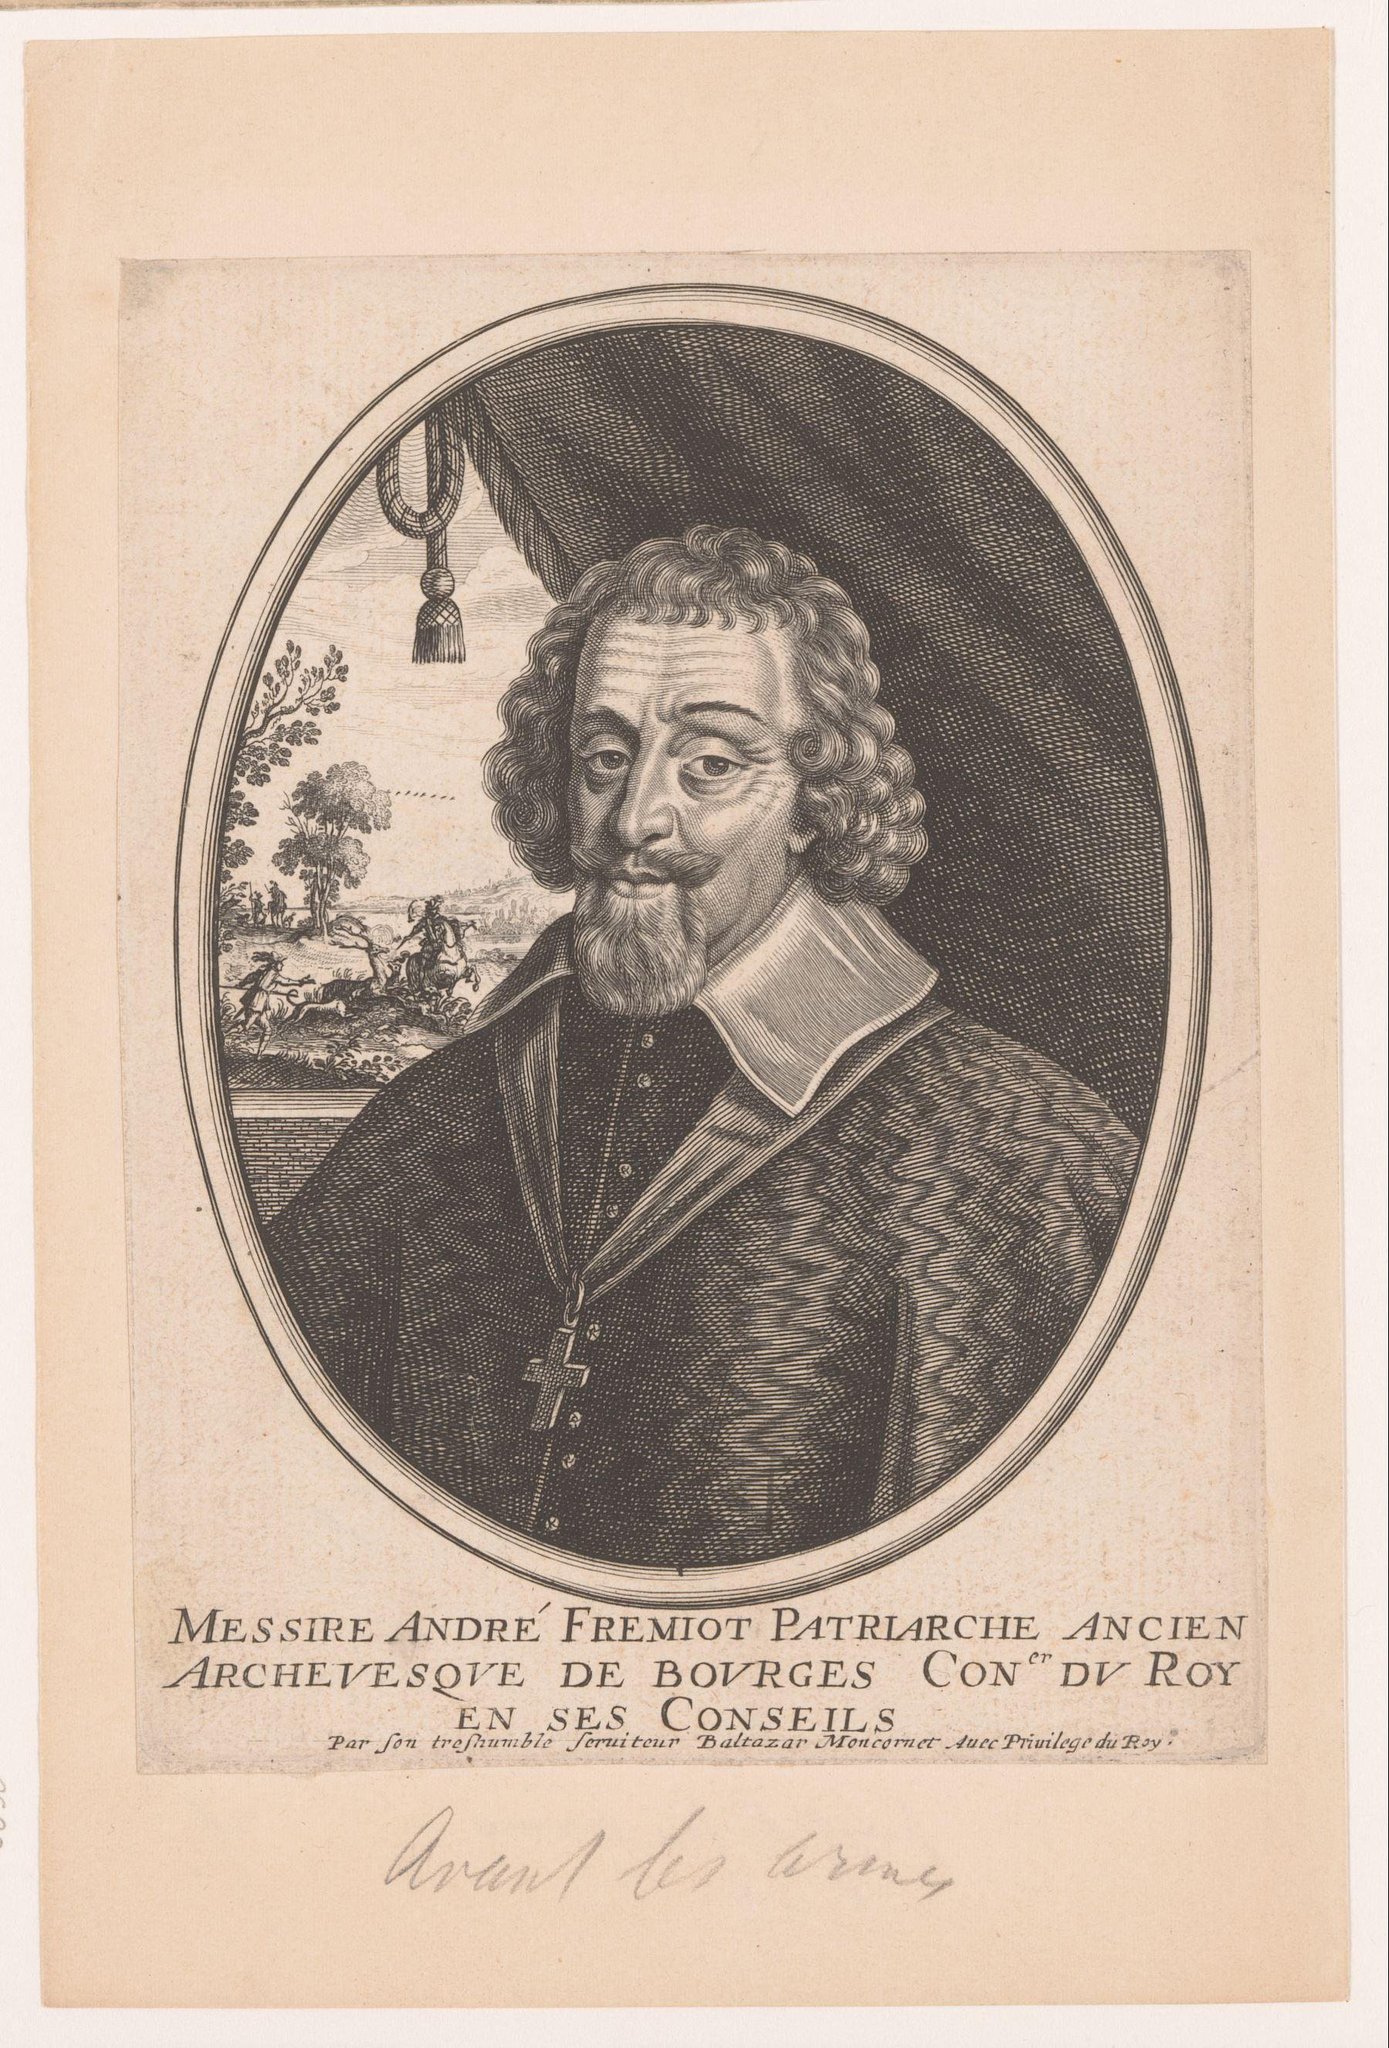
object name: print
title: Portret van André Frémiot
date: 1610-1668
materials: paper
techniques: engraving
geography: paris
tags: paris, archbishop, bishop, etc. (roman catholic), historical persons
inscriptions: collector's mark: Lugt 2228